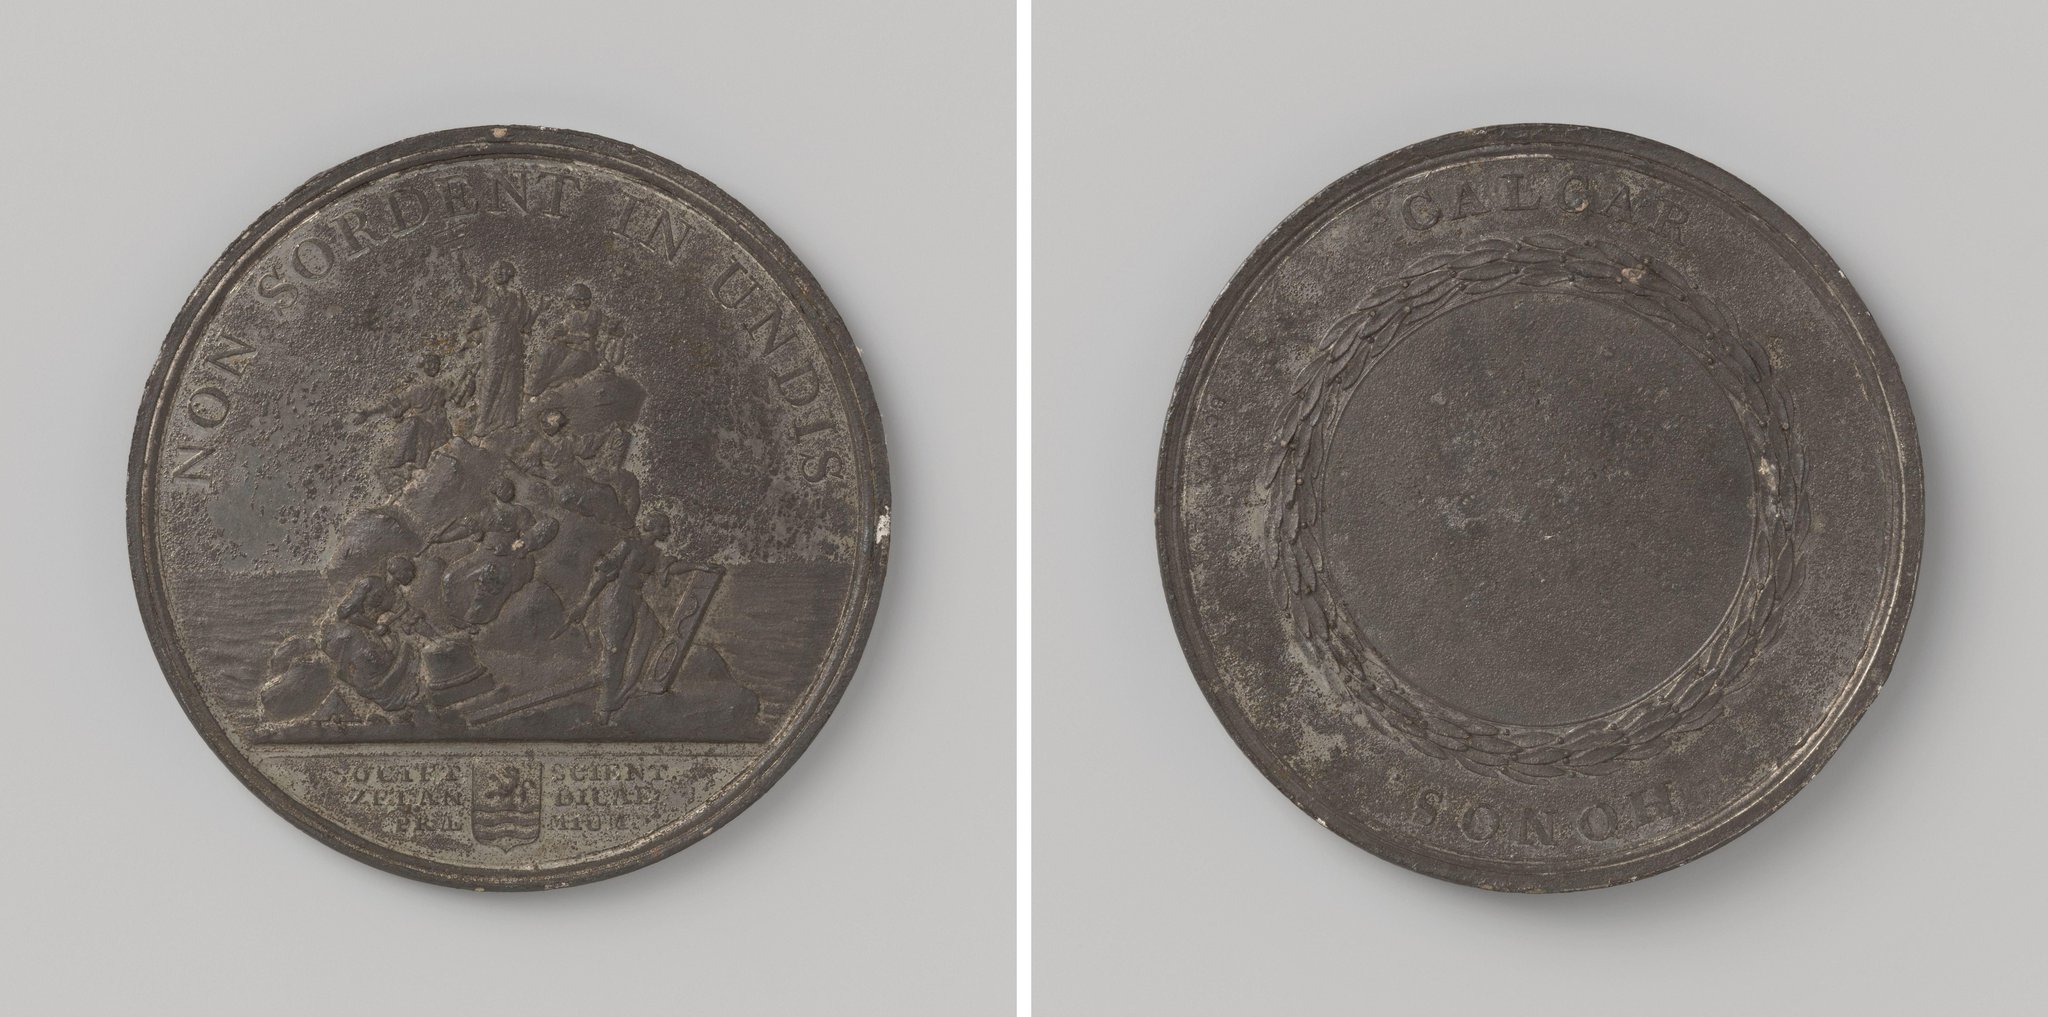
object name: medal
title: Zeeuwsch Genootschap der Wijsbegeerte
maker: barend christiaan van calker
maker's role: medailleur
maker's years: 1739-1813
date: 1769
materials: lead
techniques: striking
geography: zeist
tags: flushing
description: Loden penning. Voorzijde: zeven vrije kunsten, afgebeeld als vrouwen met hun atrributen zittend op rots, die uit zee oprijst binnen omschrift; afsnede: opschrift onderbroken door wapenschild. Keerzijde: leeg veld omgeven door lauwerkrans en omschrift